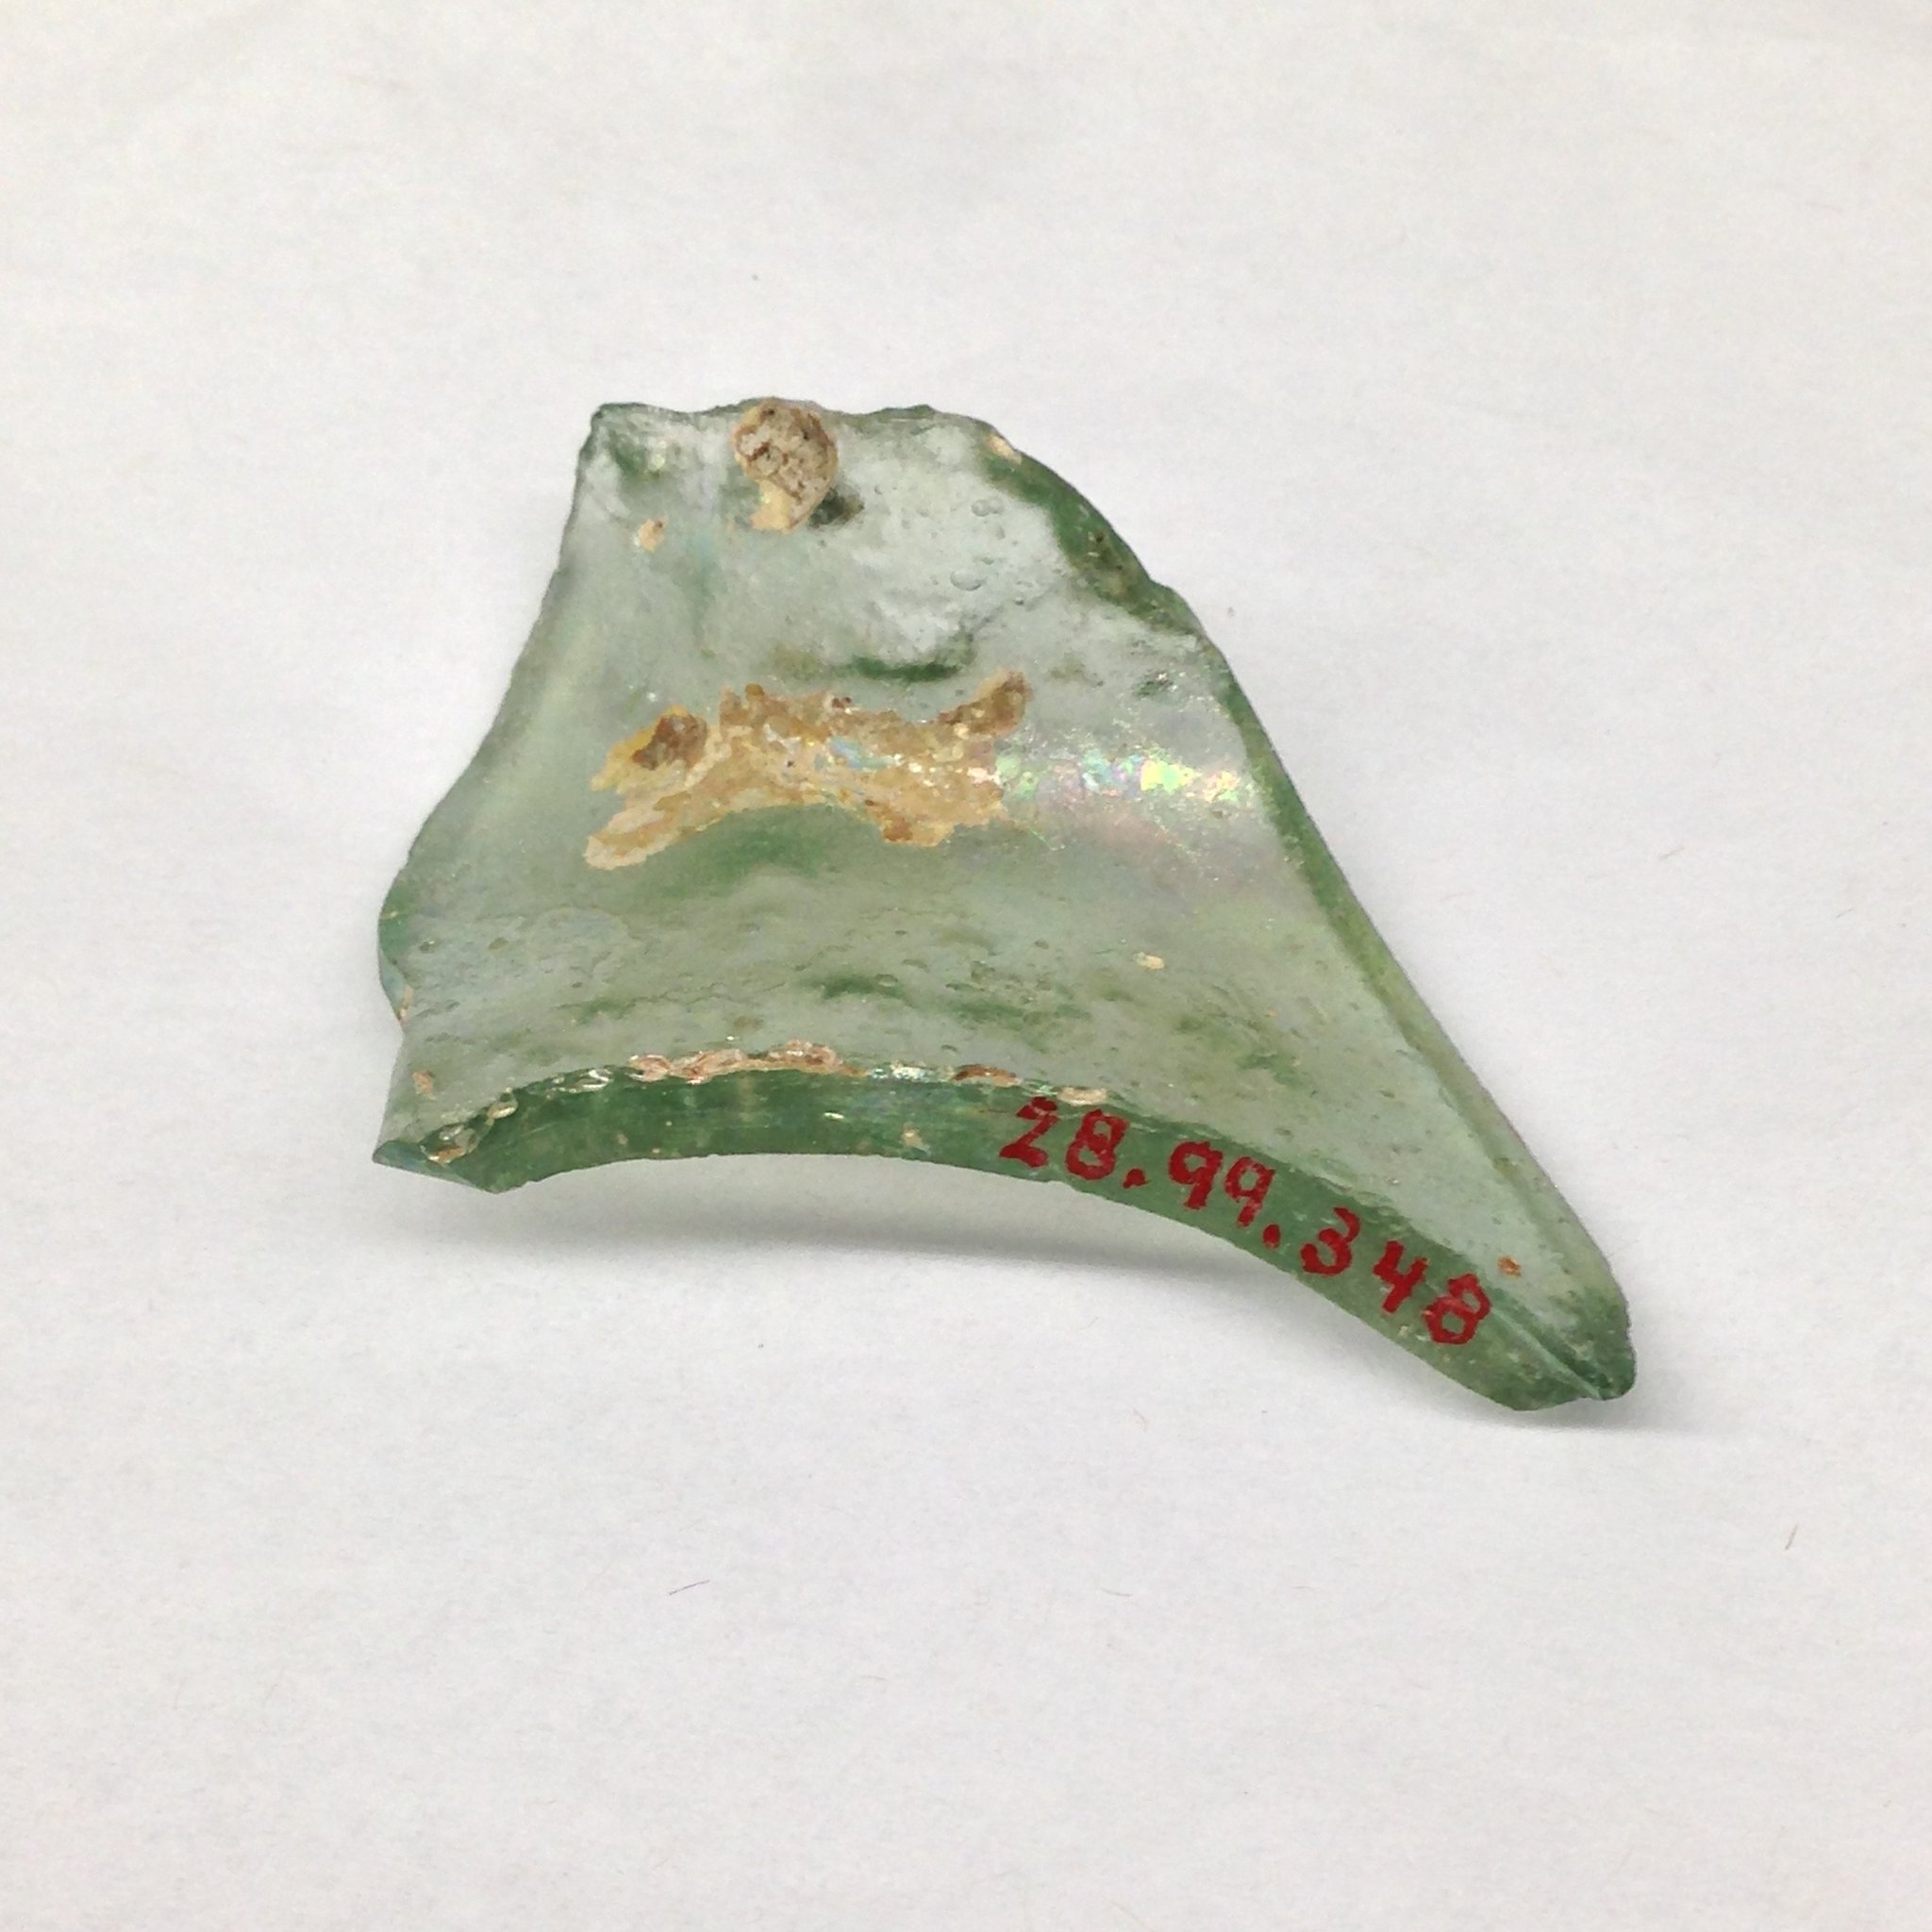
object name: fragment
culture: european or middle eastern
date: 1150-1250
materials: ceramic, glass